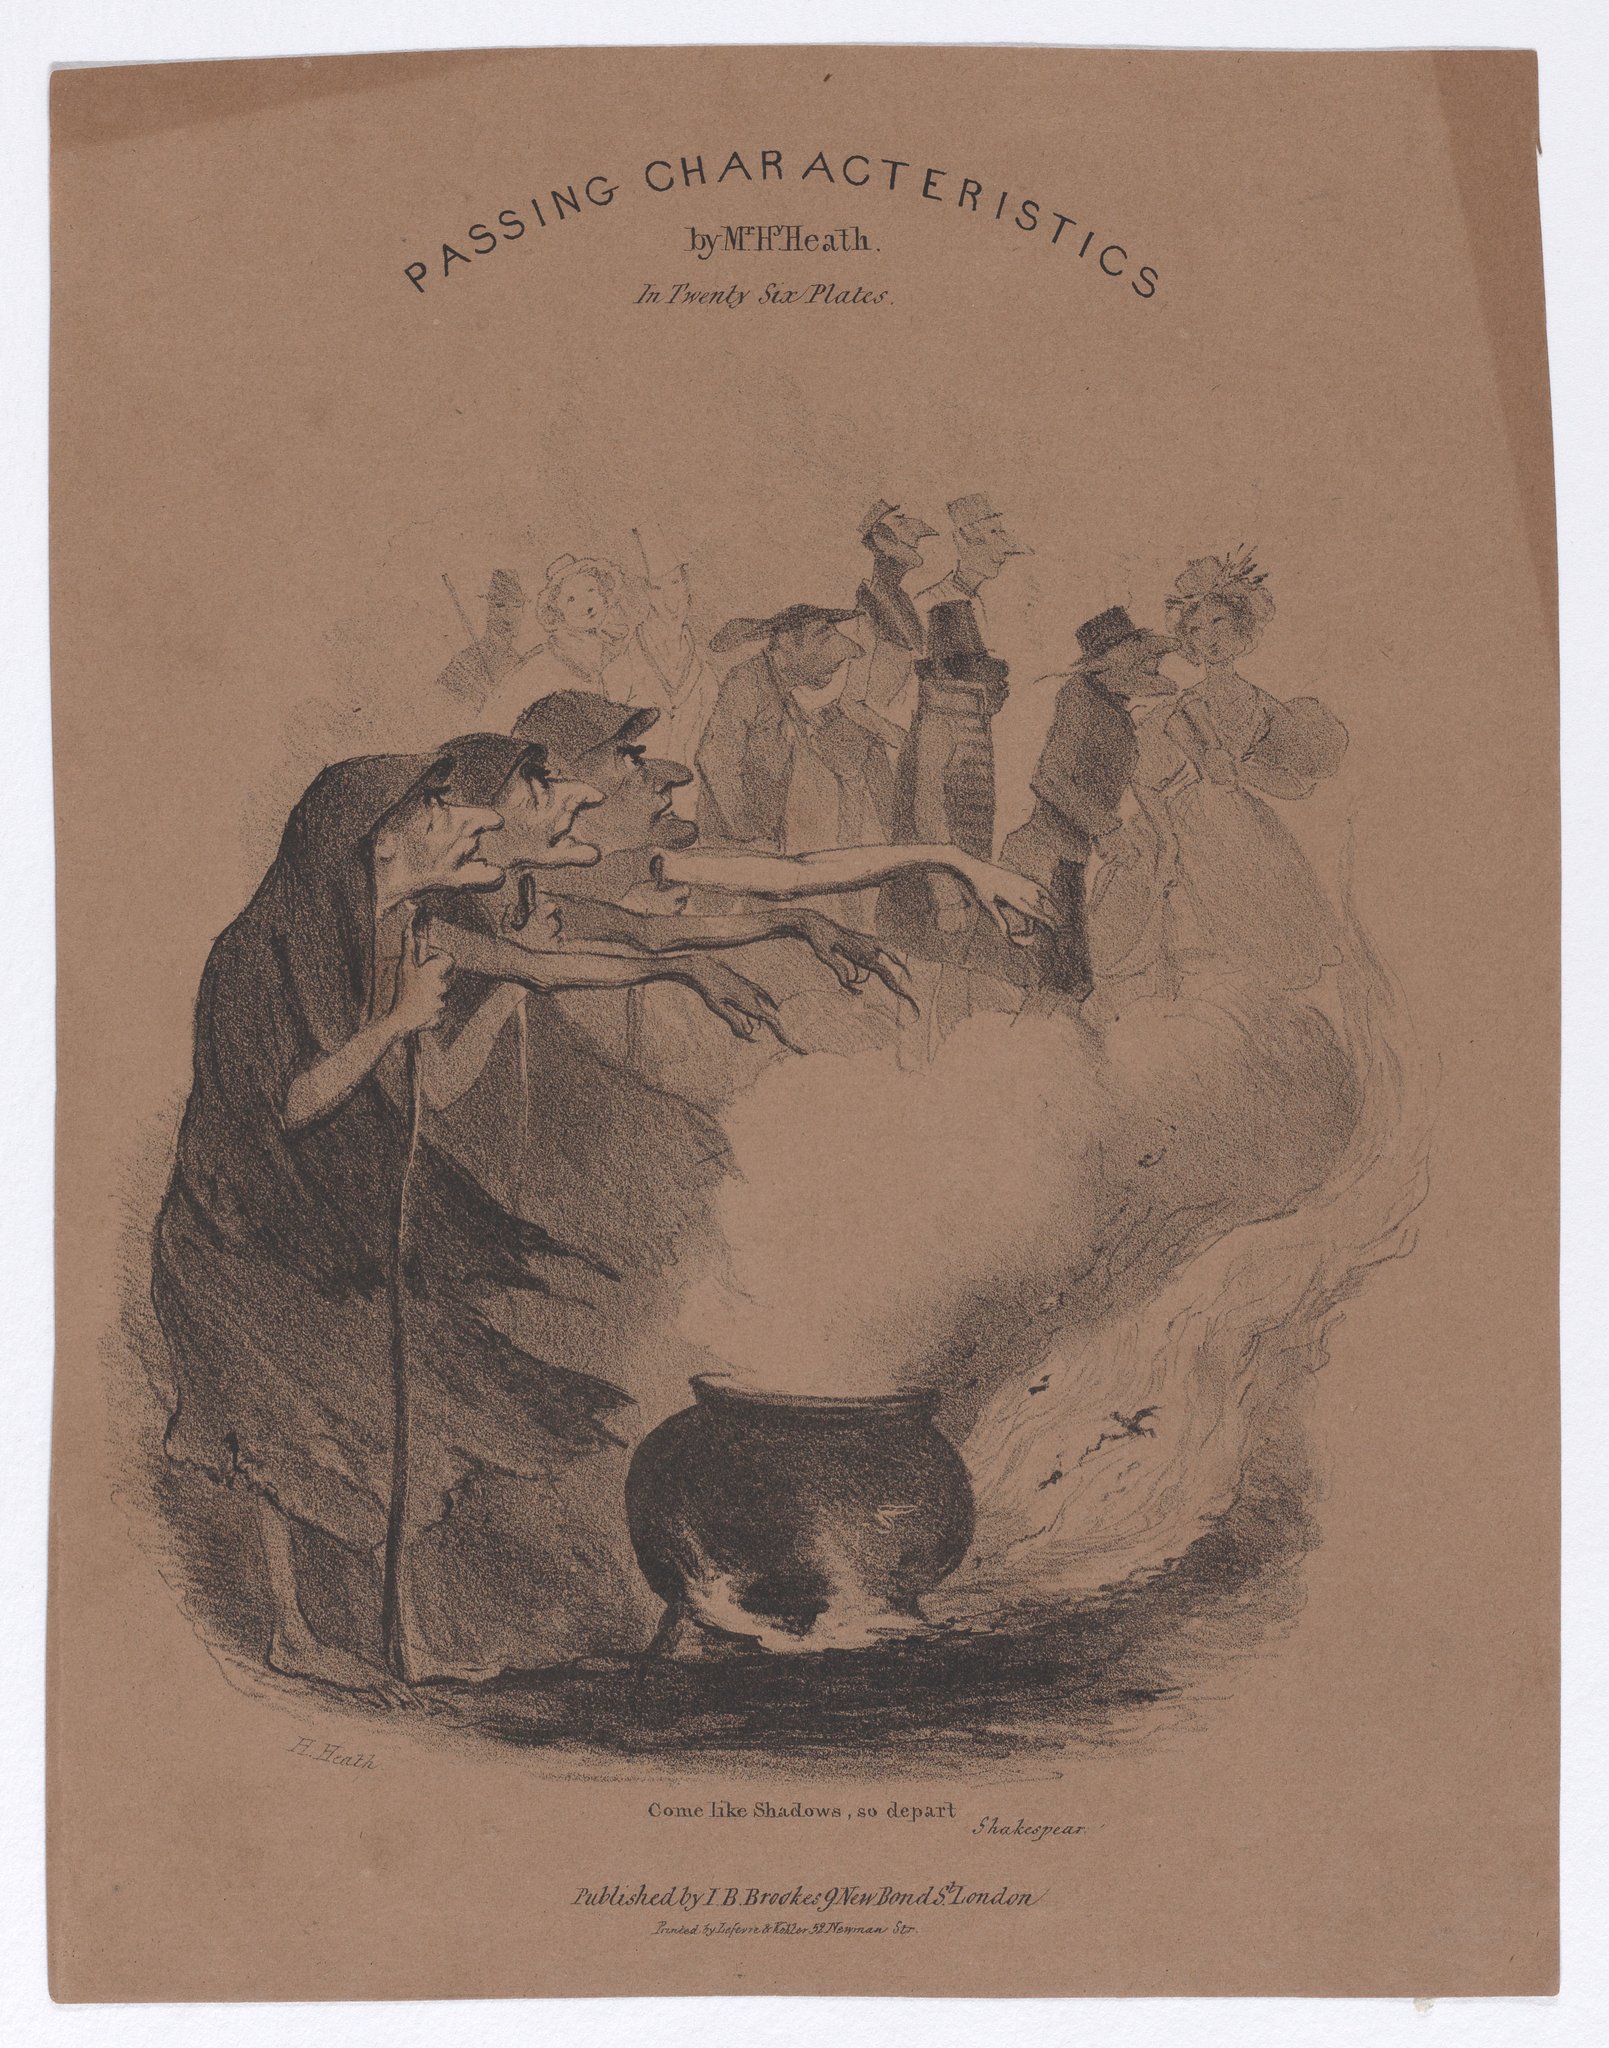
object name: print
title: Passing Characteristics in Twenty-Six Plates (cover)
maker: henry heath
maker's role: artist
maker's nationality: british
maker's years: 1801-1858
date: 1840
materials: paper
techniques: lithograph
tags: men,women,cauldrons